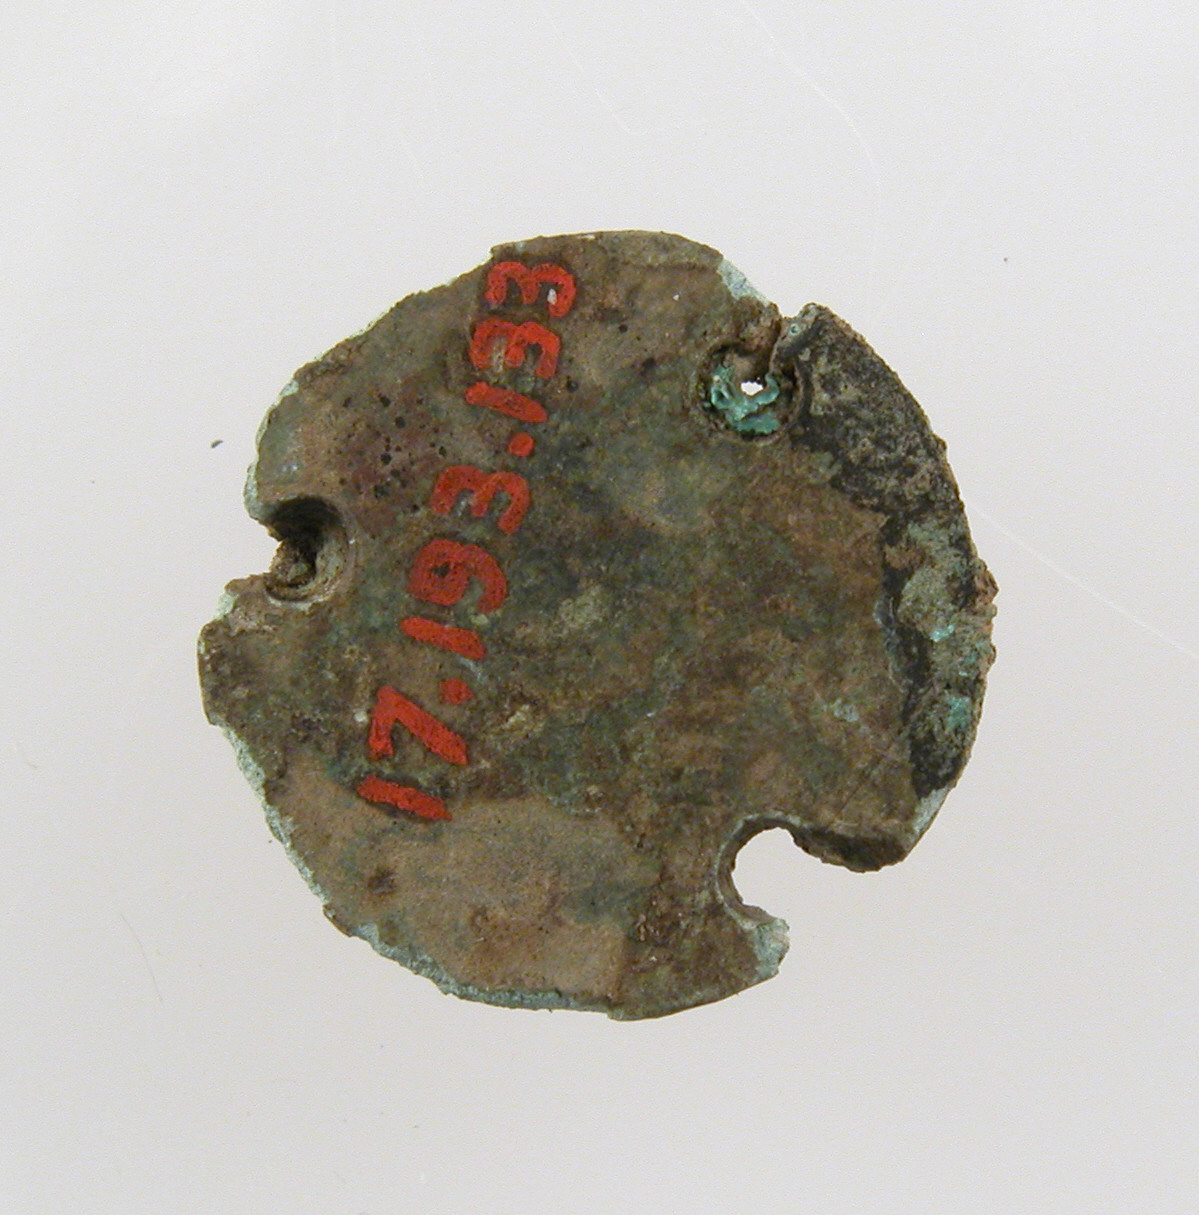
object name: belt fitting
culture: frankish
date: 501-700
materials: copper alloy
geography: germany